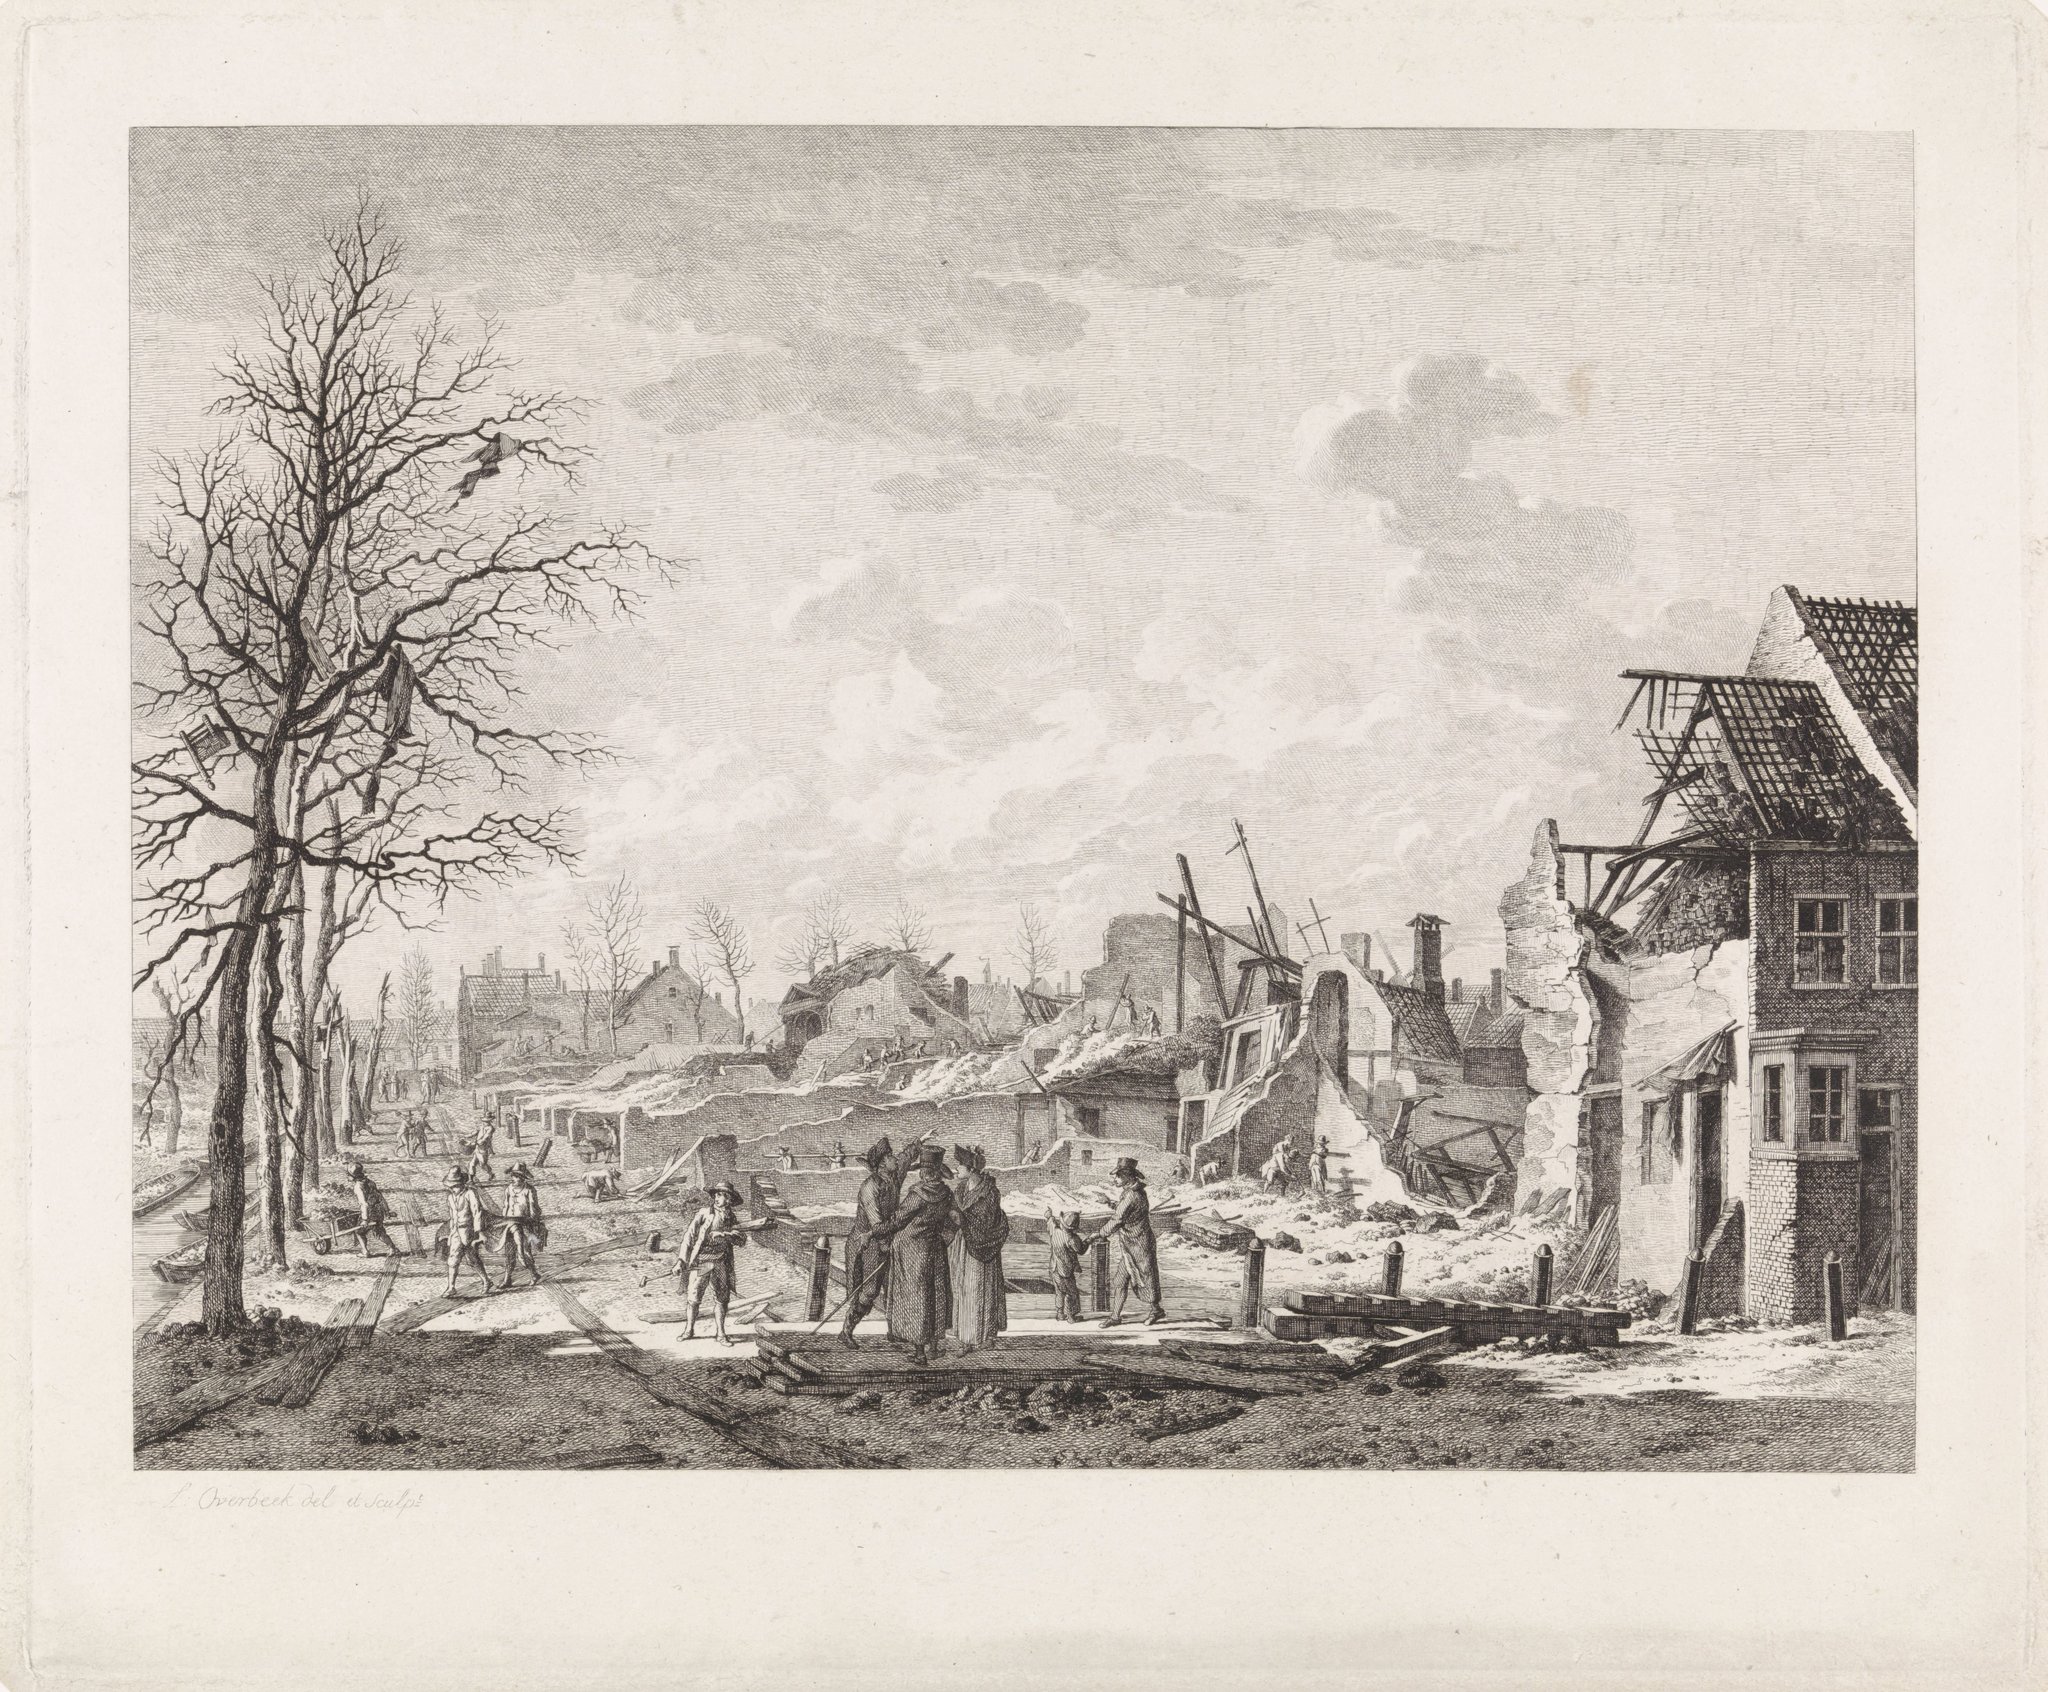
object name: print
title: Gezicht op het Rapenburg te Leiden na de buskruitramp van 12 januari 1807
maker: leendert overbeek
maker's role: draughtsman, painter, print maker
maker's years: 1752-1815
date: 1807-1809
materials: paper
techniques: etching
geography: haarlem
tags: gunpowder disaster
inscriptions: collector's mark: Lugt 2228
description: Gezicht op het Steenschuur, een gracht in het verlengde van het Rapenburg, te Leiden na de fatale buskruitramp van 12 januari 1807. Reddingswerkers proberen gewonden te bergen. Linksvoor dragen twee mannen een lichaam op een draagbar. In de bomen langs de gracht hangt huisraad en kleding dat door de druk de lucht in geslingerd is.